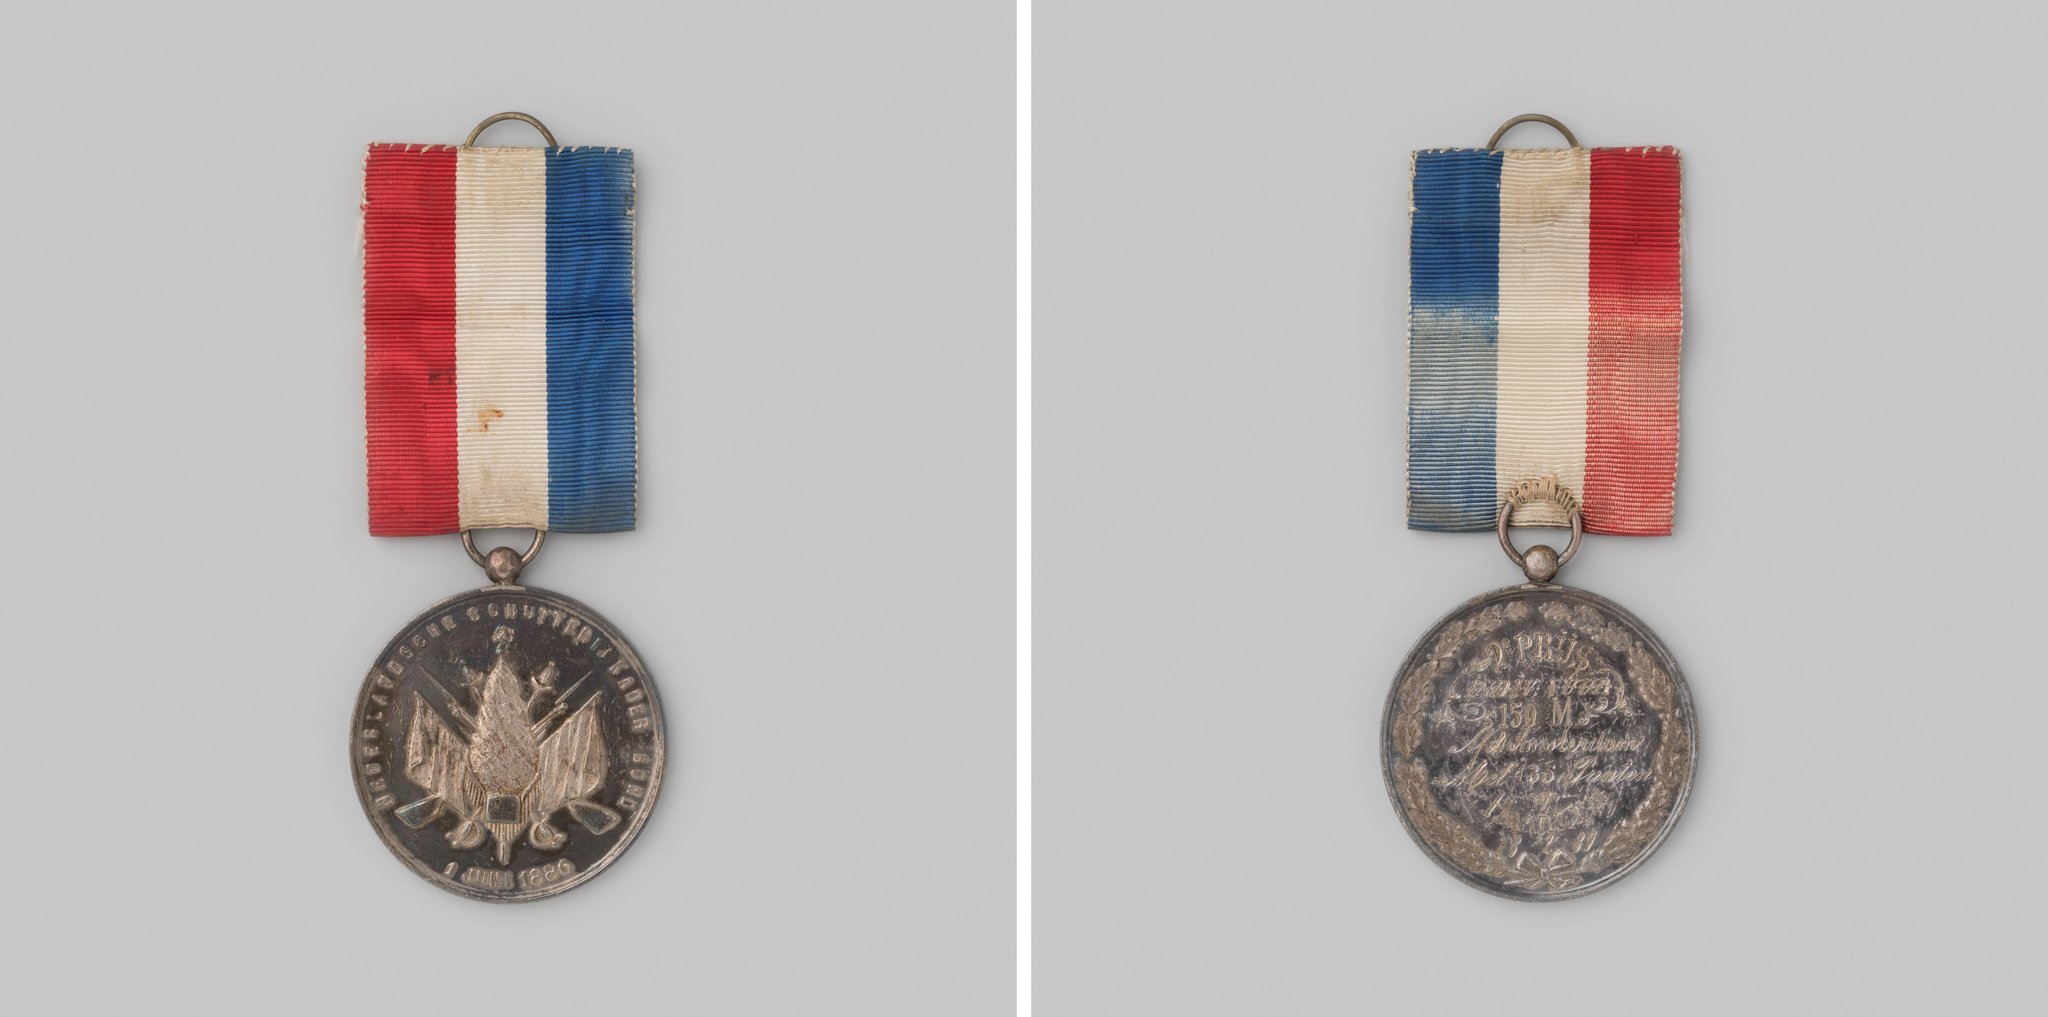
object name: draagpenning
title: Prijspenning van de Nederlandsche Schutterij-Kaderbond, 1889, individueel vuur, tweede prijs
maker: Anonymous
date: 1889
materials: silver, textile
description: Zilveren penning. Prijspenning van de Nederlandsche Schutterij-Kaderbond, te Haarlem behaald, 1889. Rood-wit-blauw geribd zijden lint. Voorzijde: een trofee van wapens en vaandels gedekt door het korpsvaandel. Omschrift: NEDERLANDSCHE SCHUTTERIJ KADER BOND. 1 JUNI 1889. Keerzijde 2de PRIJS / INDIV: VUUR / 150 M / Afd. Amsterdam / met 135 punten / HAARLEM 18-89 29/7. Het geheel omgeven met eikenloof.